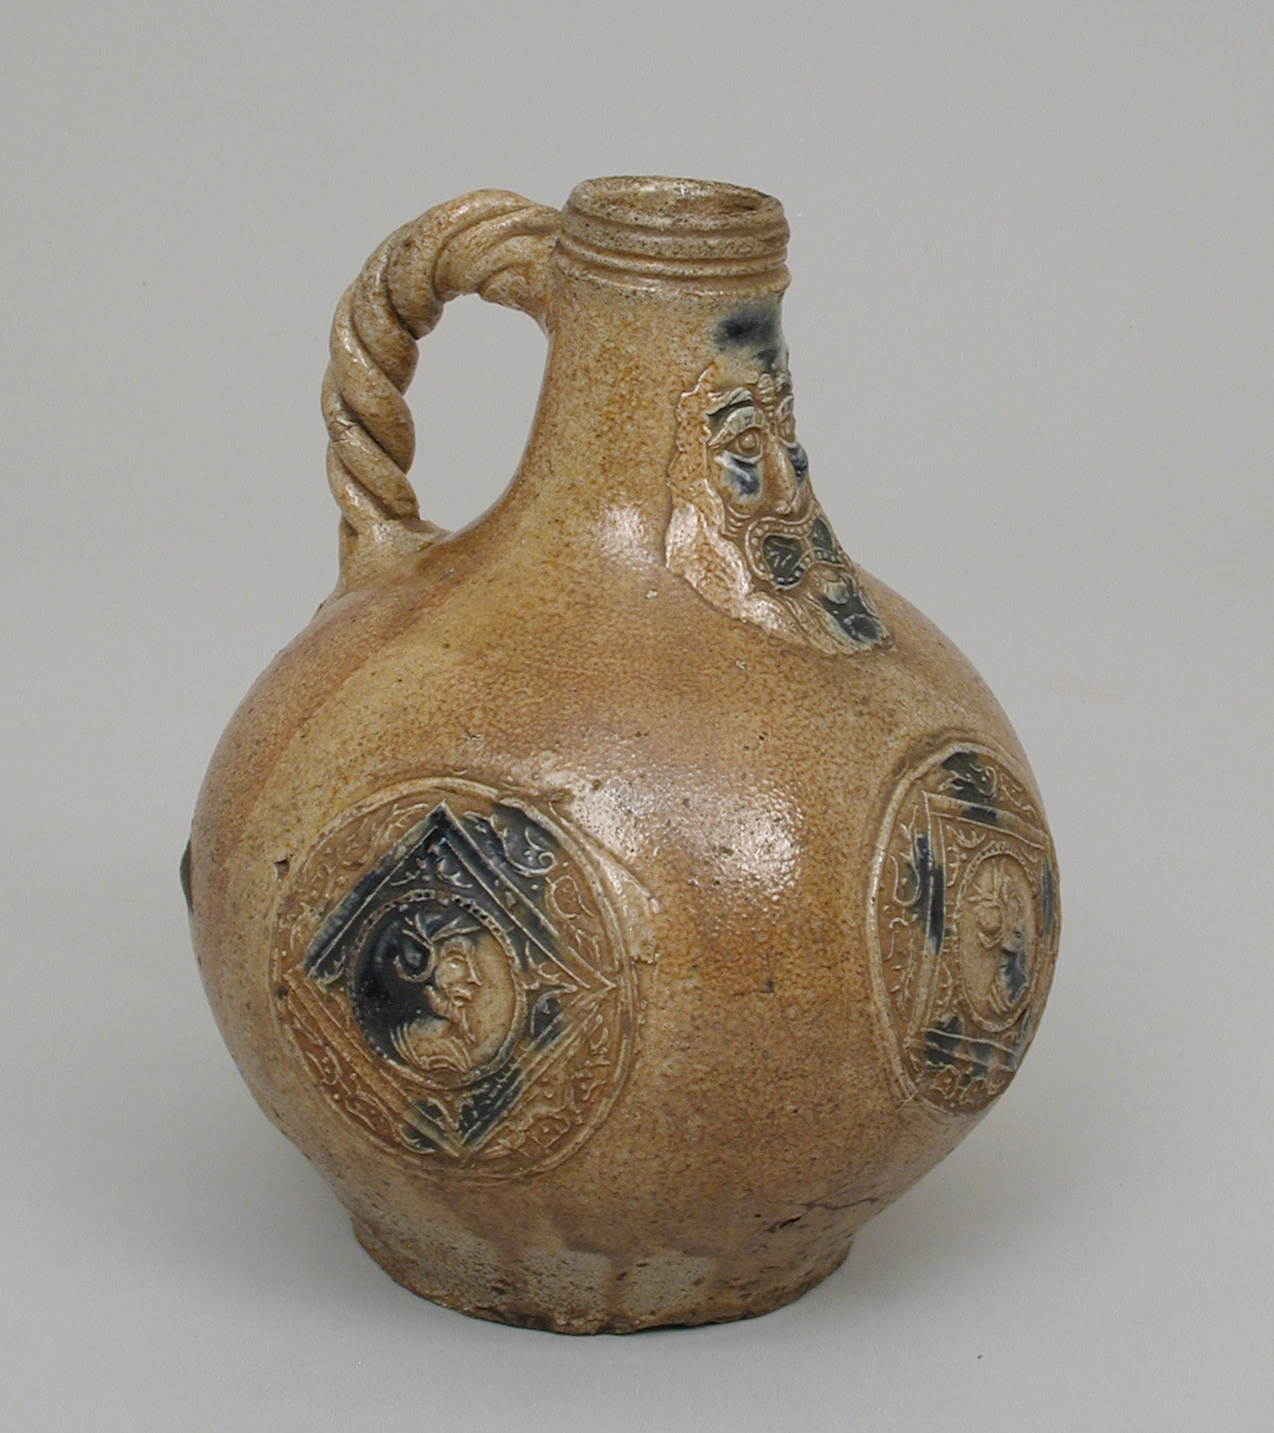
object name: jug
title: Beardman or Bellarmine jug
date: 1601-1700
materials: stoneware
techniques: salt glaze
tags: faces,men,profiles